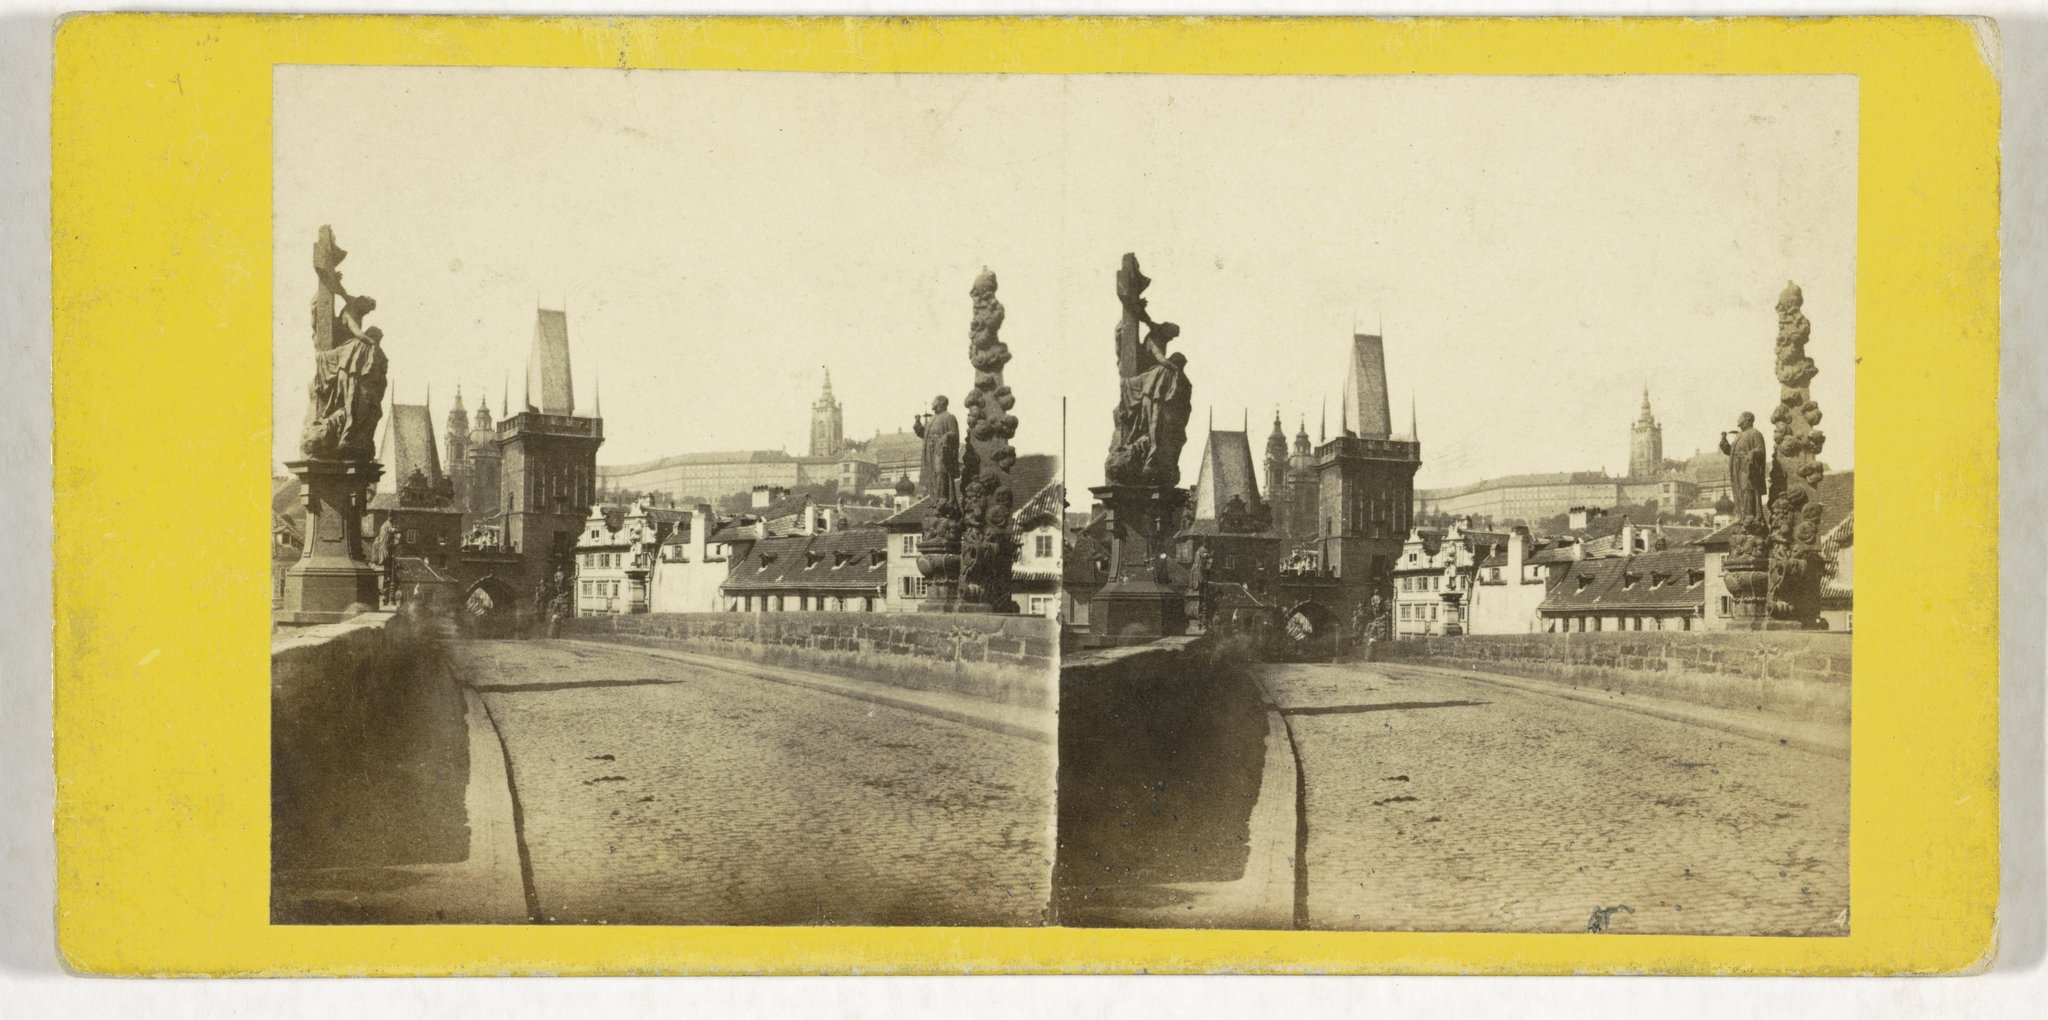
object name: stereograph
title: Karelsbrug gezien richting Malá Strana, Praag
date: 1861-1870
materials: cardboard, paper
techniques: albumen print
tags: city-view in general; 'veduta', bridge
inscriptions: number: ‘No 410’